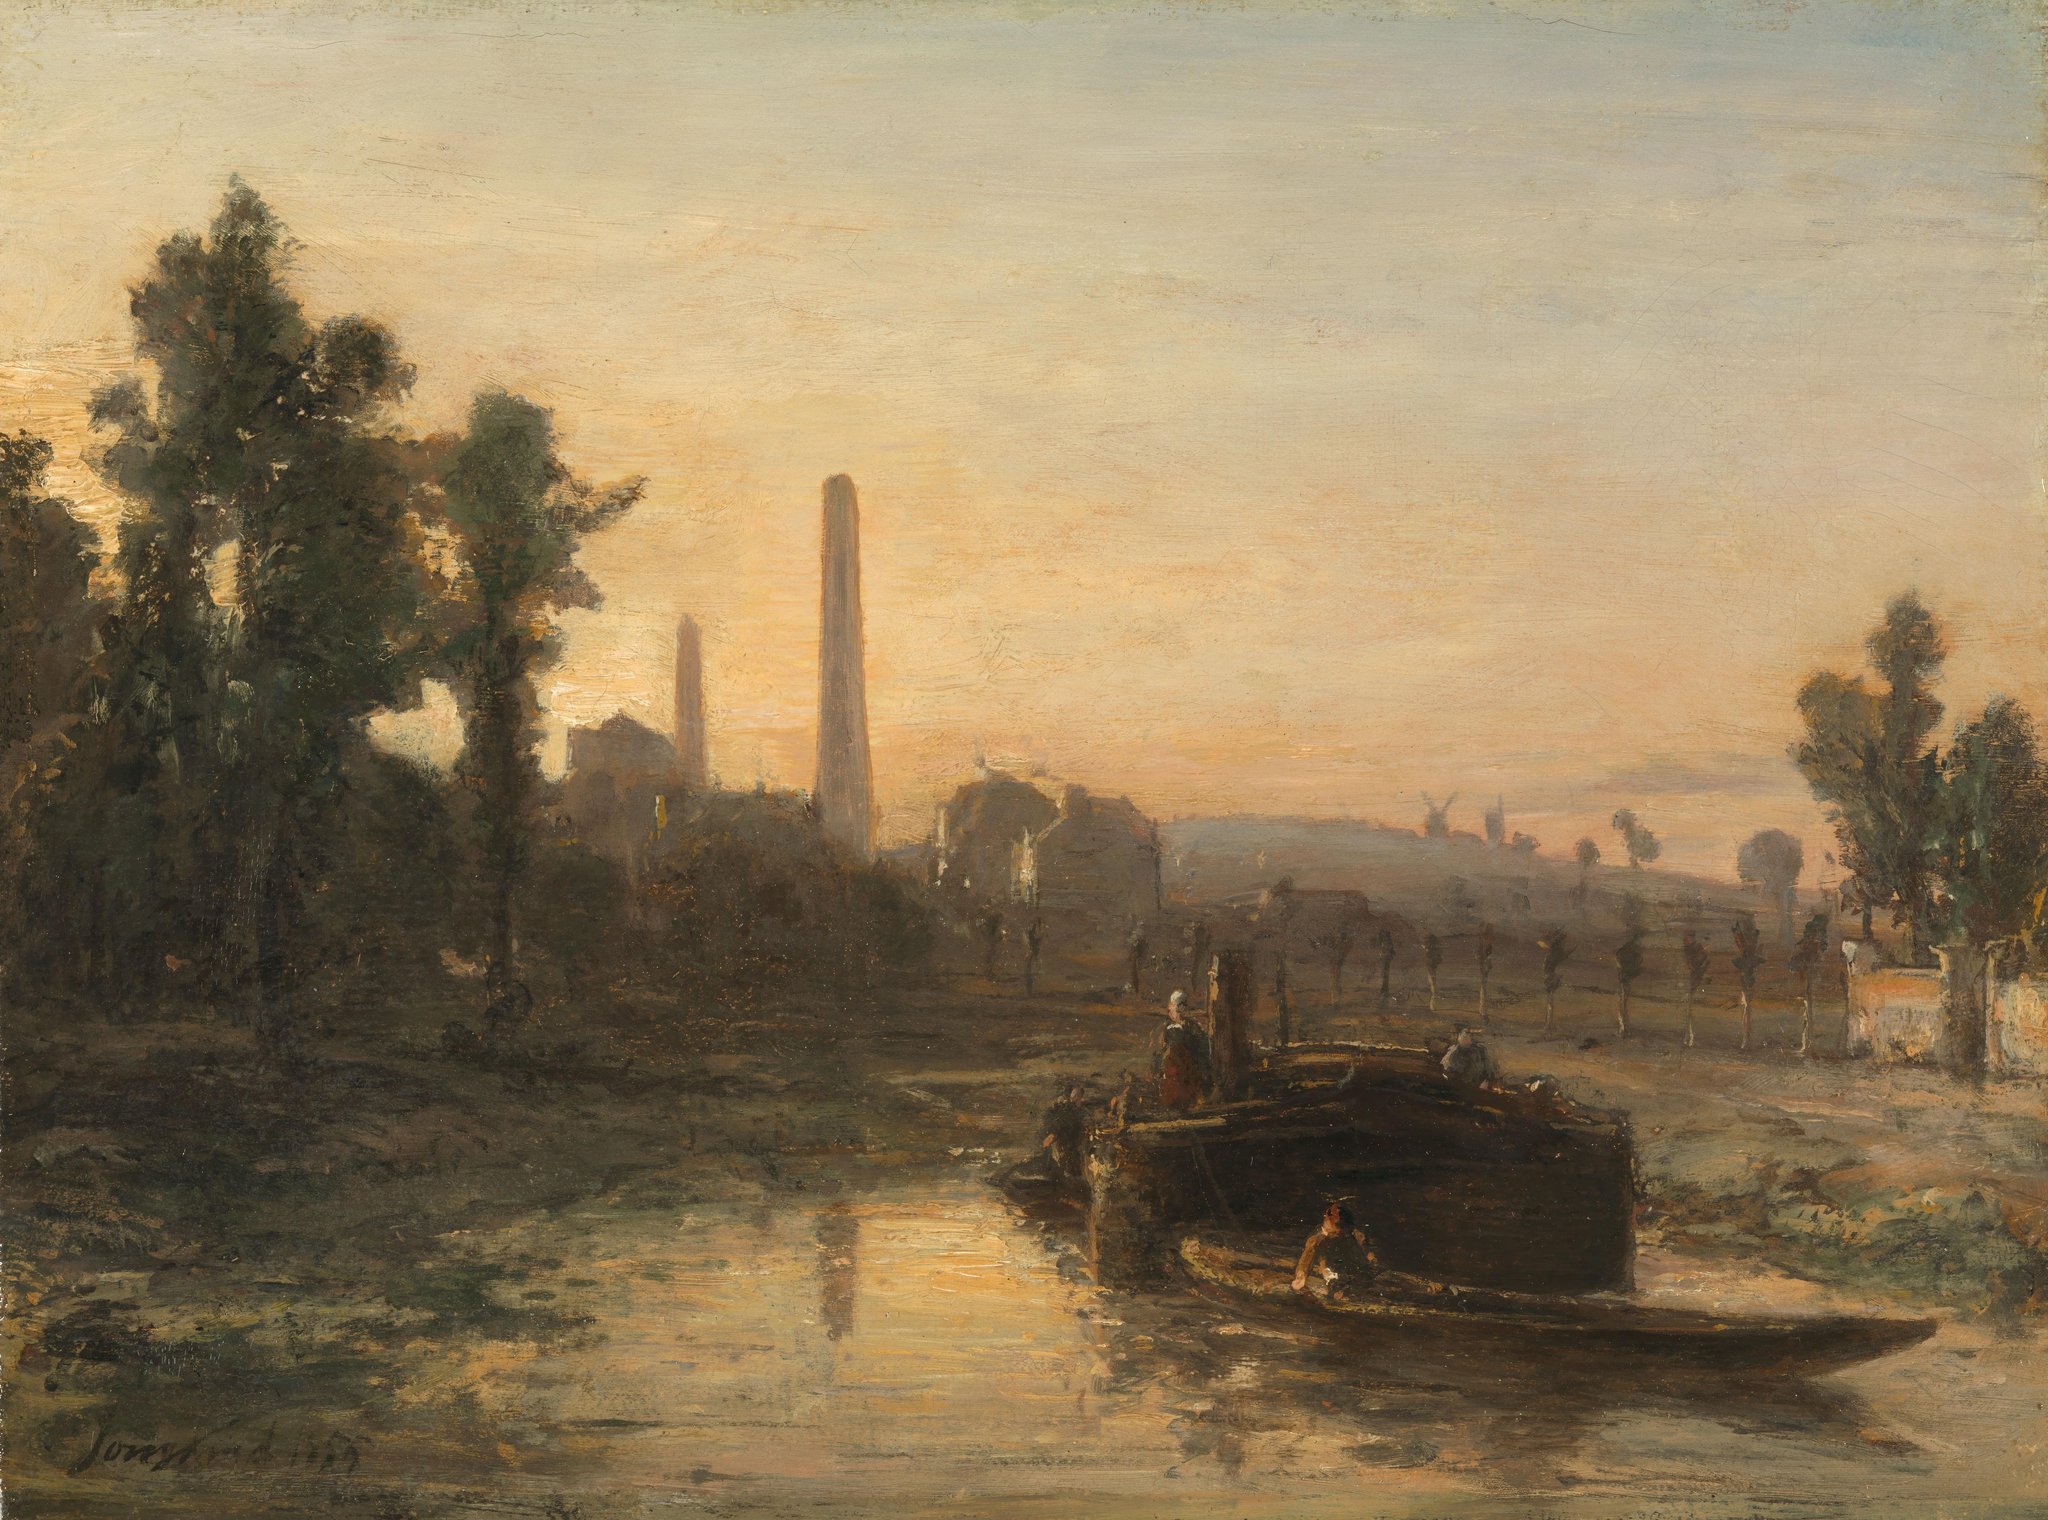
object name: painting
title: River View in France, possibly near Pontoise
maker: johan barthold jongkind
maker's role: draughtsman, painter, print maker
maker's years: 1819-1891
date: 1855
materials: canvas, oil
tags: factory-building, river, factory in landscape, france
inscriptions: signature and date: ‘Jongkind 1855’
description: Riviergezicht in Frankrijk, mogelijk nabij Pontoise. Op de voorgrond een schuit en kleine boten op het water. Op de achtergrond heuvels met bomen en een molen, links de torens van fabrieken.